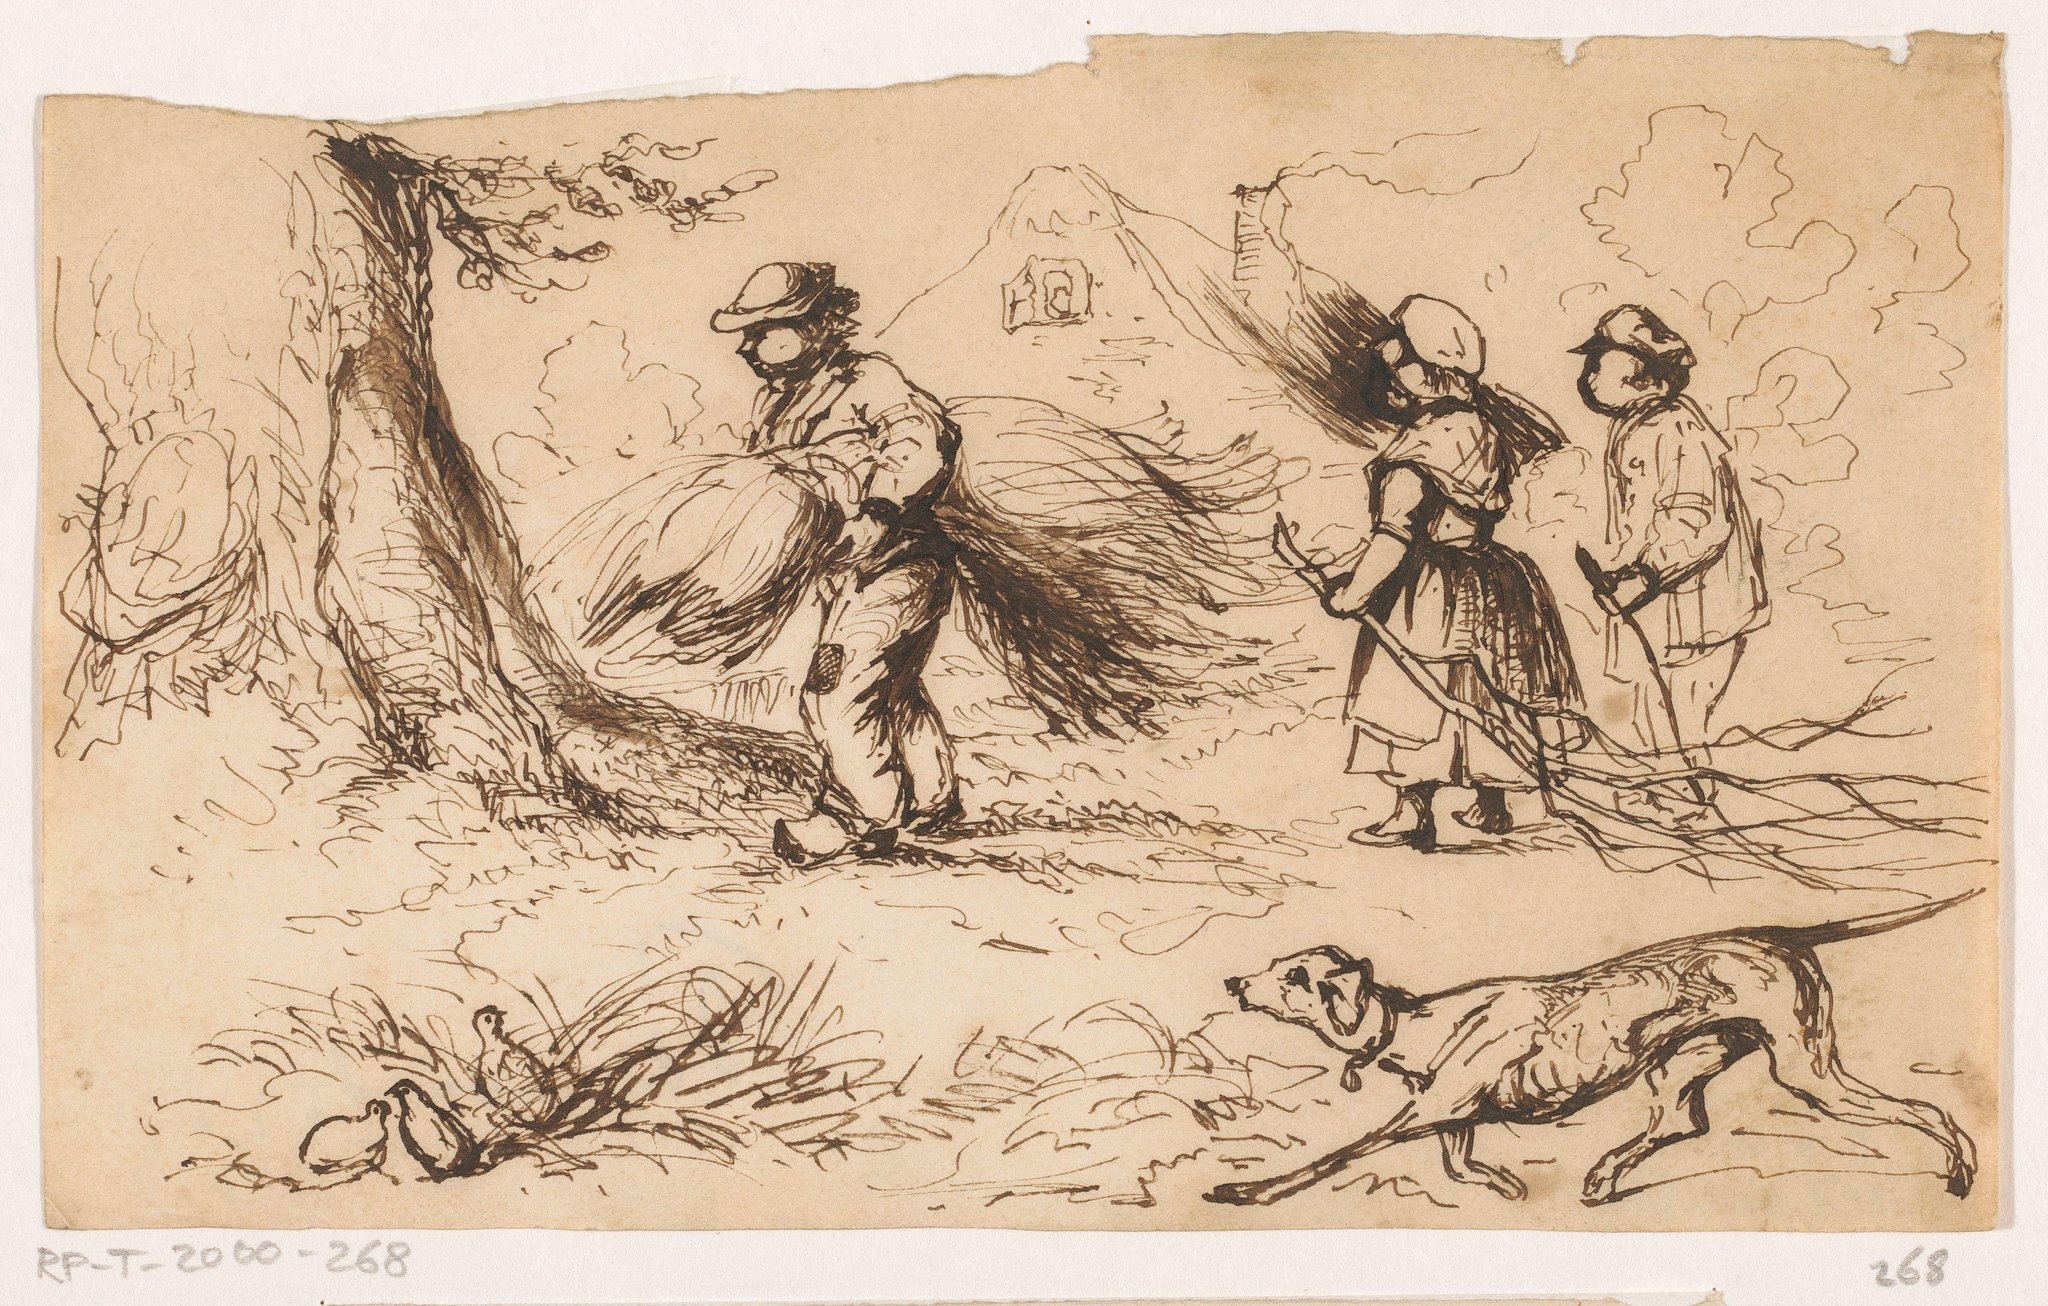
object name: drawing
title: Twee figuren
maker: johannes tavenraat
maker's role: draughtsman, painter, print maker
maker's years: 1809-1881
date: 1840-1880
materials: paper, pencil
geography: cleves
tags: standing figure, standing figure - aa - female human figure, cleves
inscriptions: collector's mark: Lugt 2228, signature: ‘Tavenraat Cleve’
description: Schetsen van een vrouw met pak op de rug en een man lopend met een stok, te Kleef.